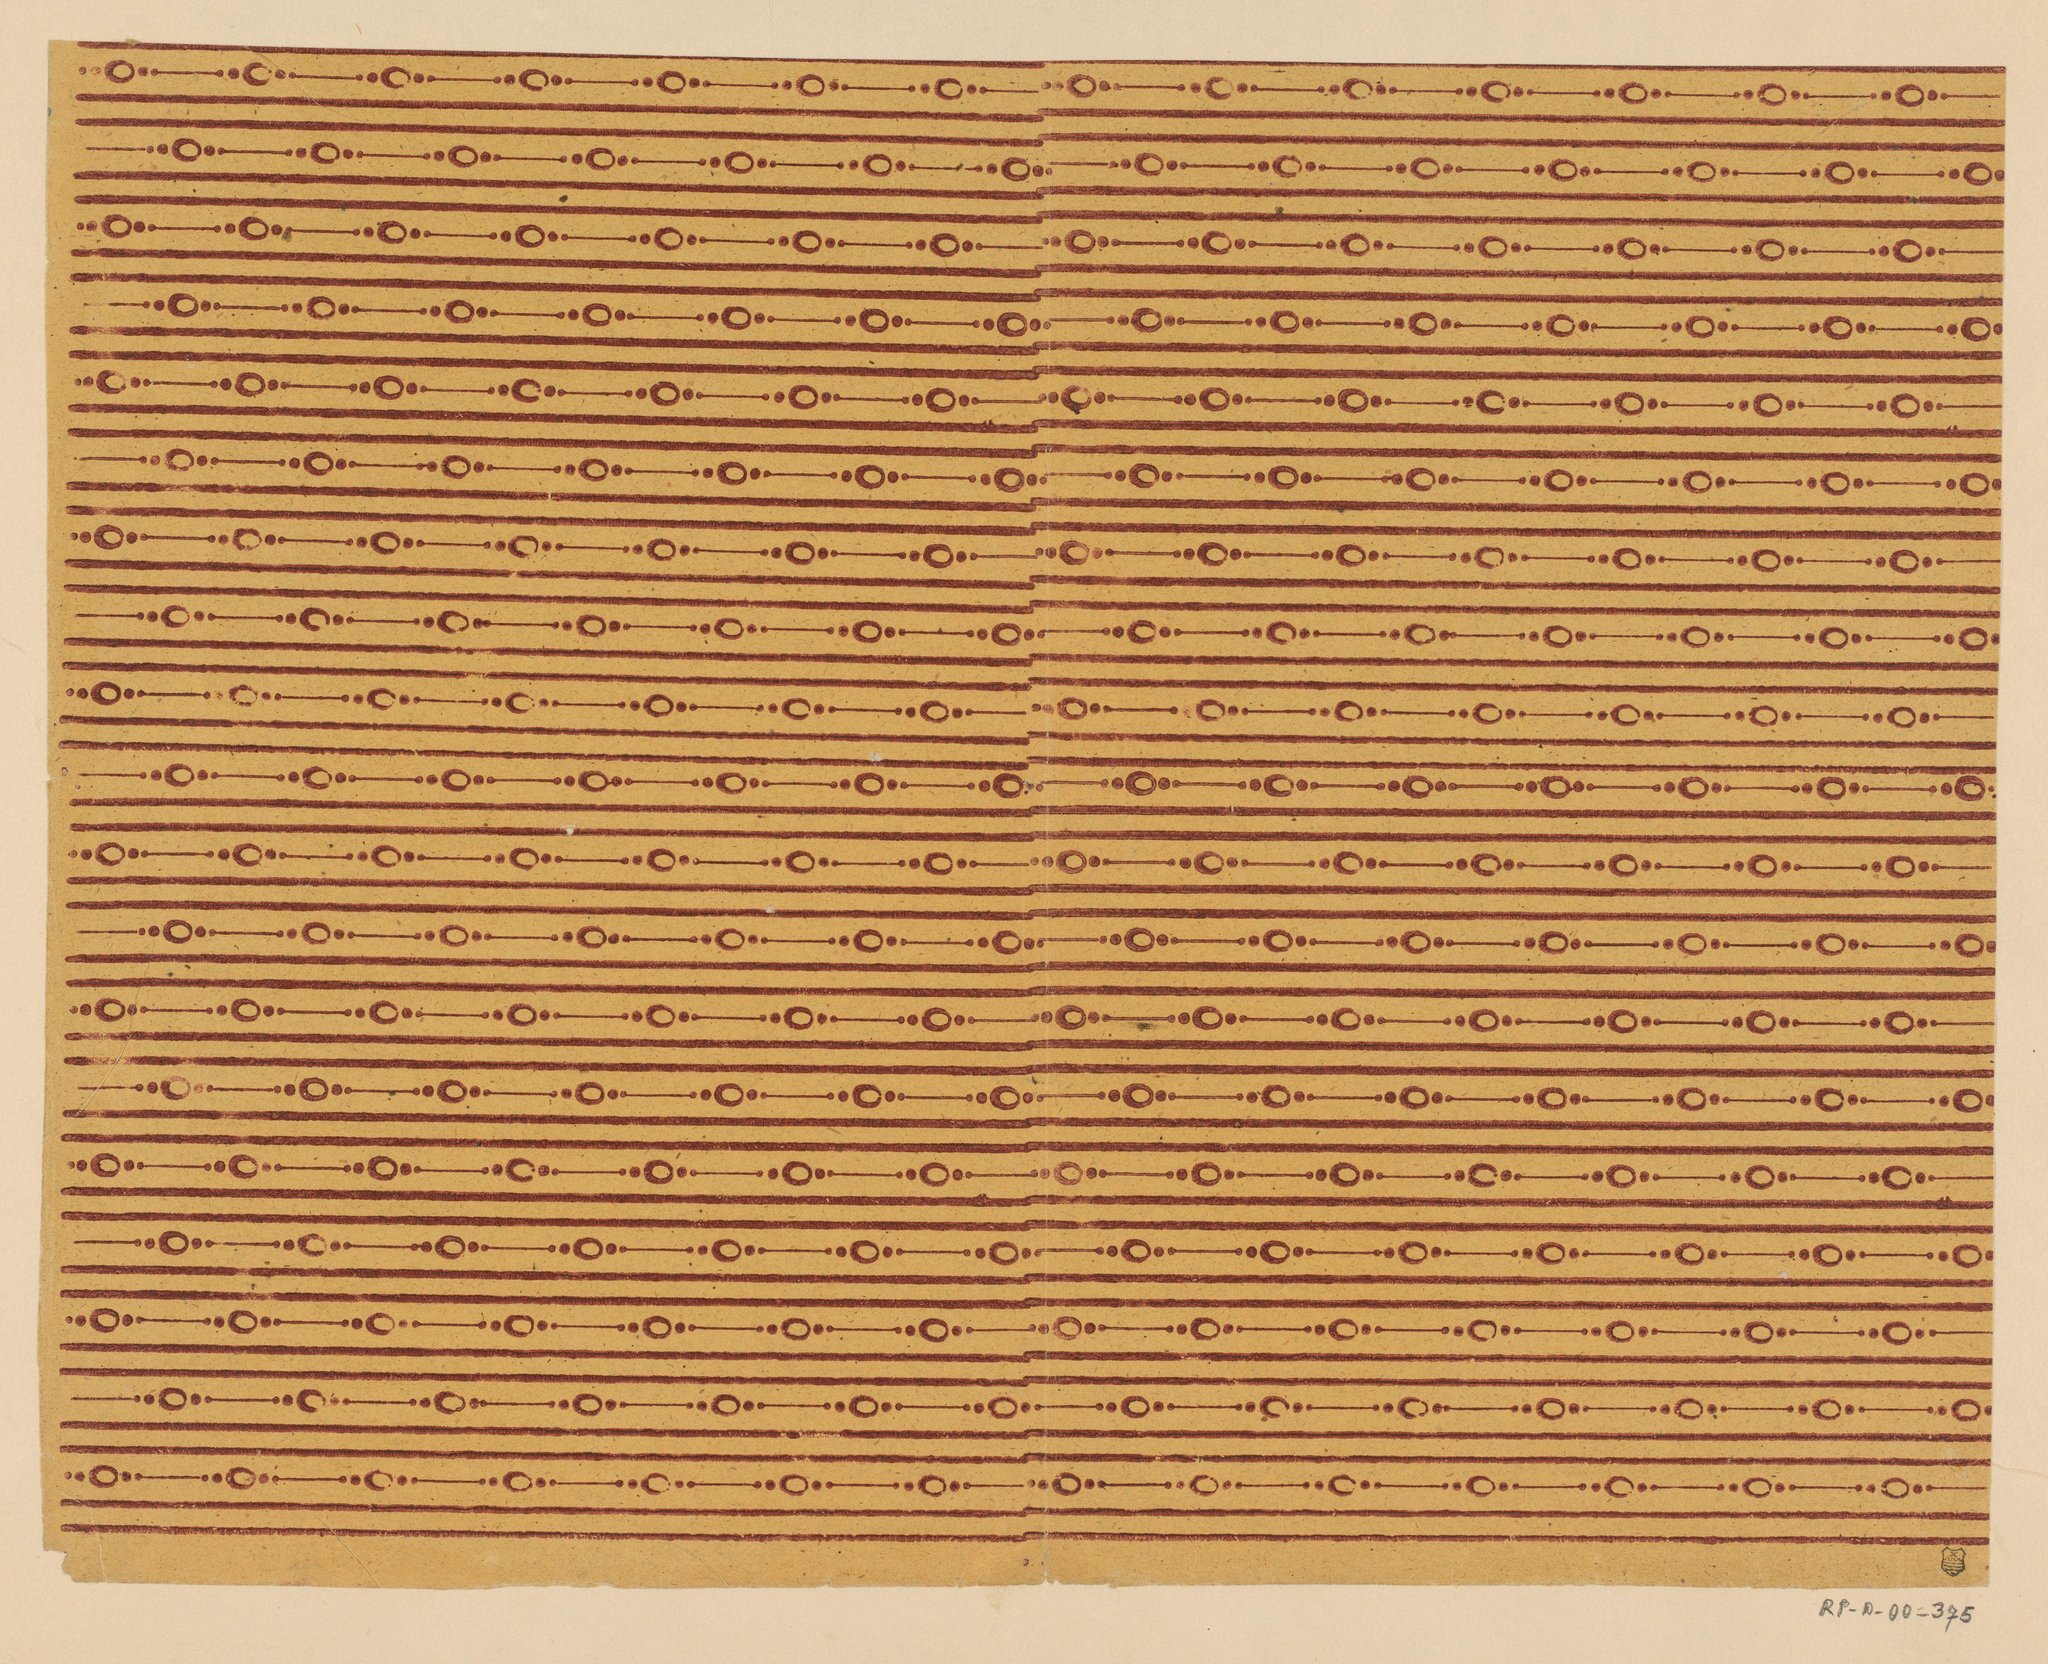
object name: printed paper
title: Blad met banenpatroon met ovaal motief met streep en stippen afgewisseld met twee strepen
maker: Anonymous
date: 1700-1850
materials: paper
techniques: printing block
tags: ornament ~ geometric motifs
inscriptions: collector's mark: Lugt 2760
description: Blad met banenpatroon met ovaal motief met streep en stippen afgewisseld met twee strepen.